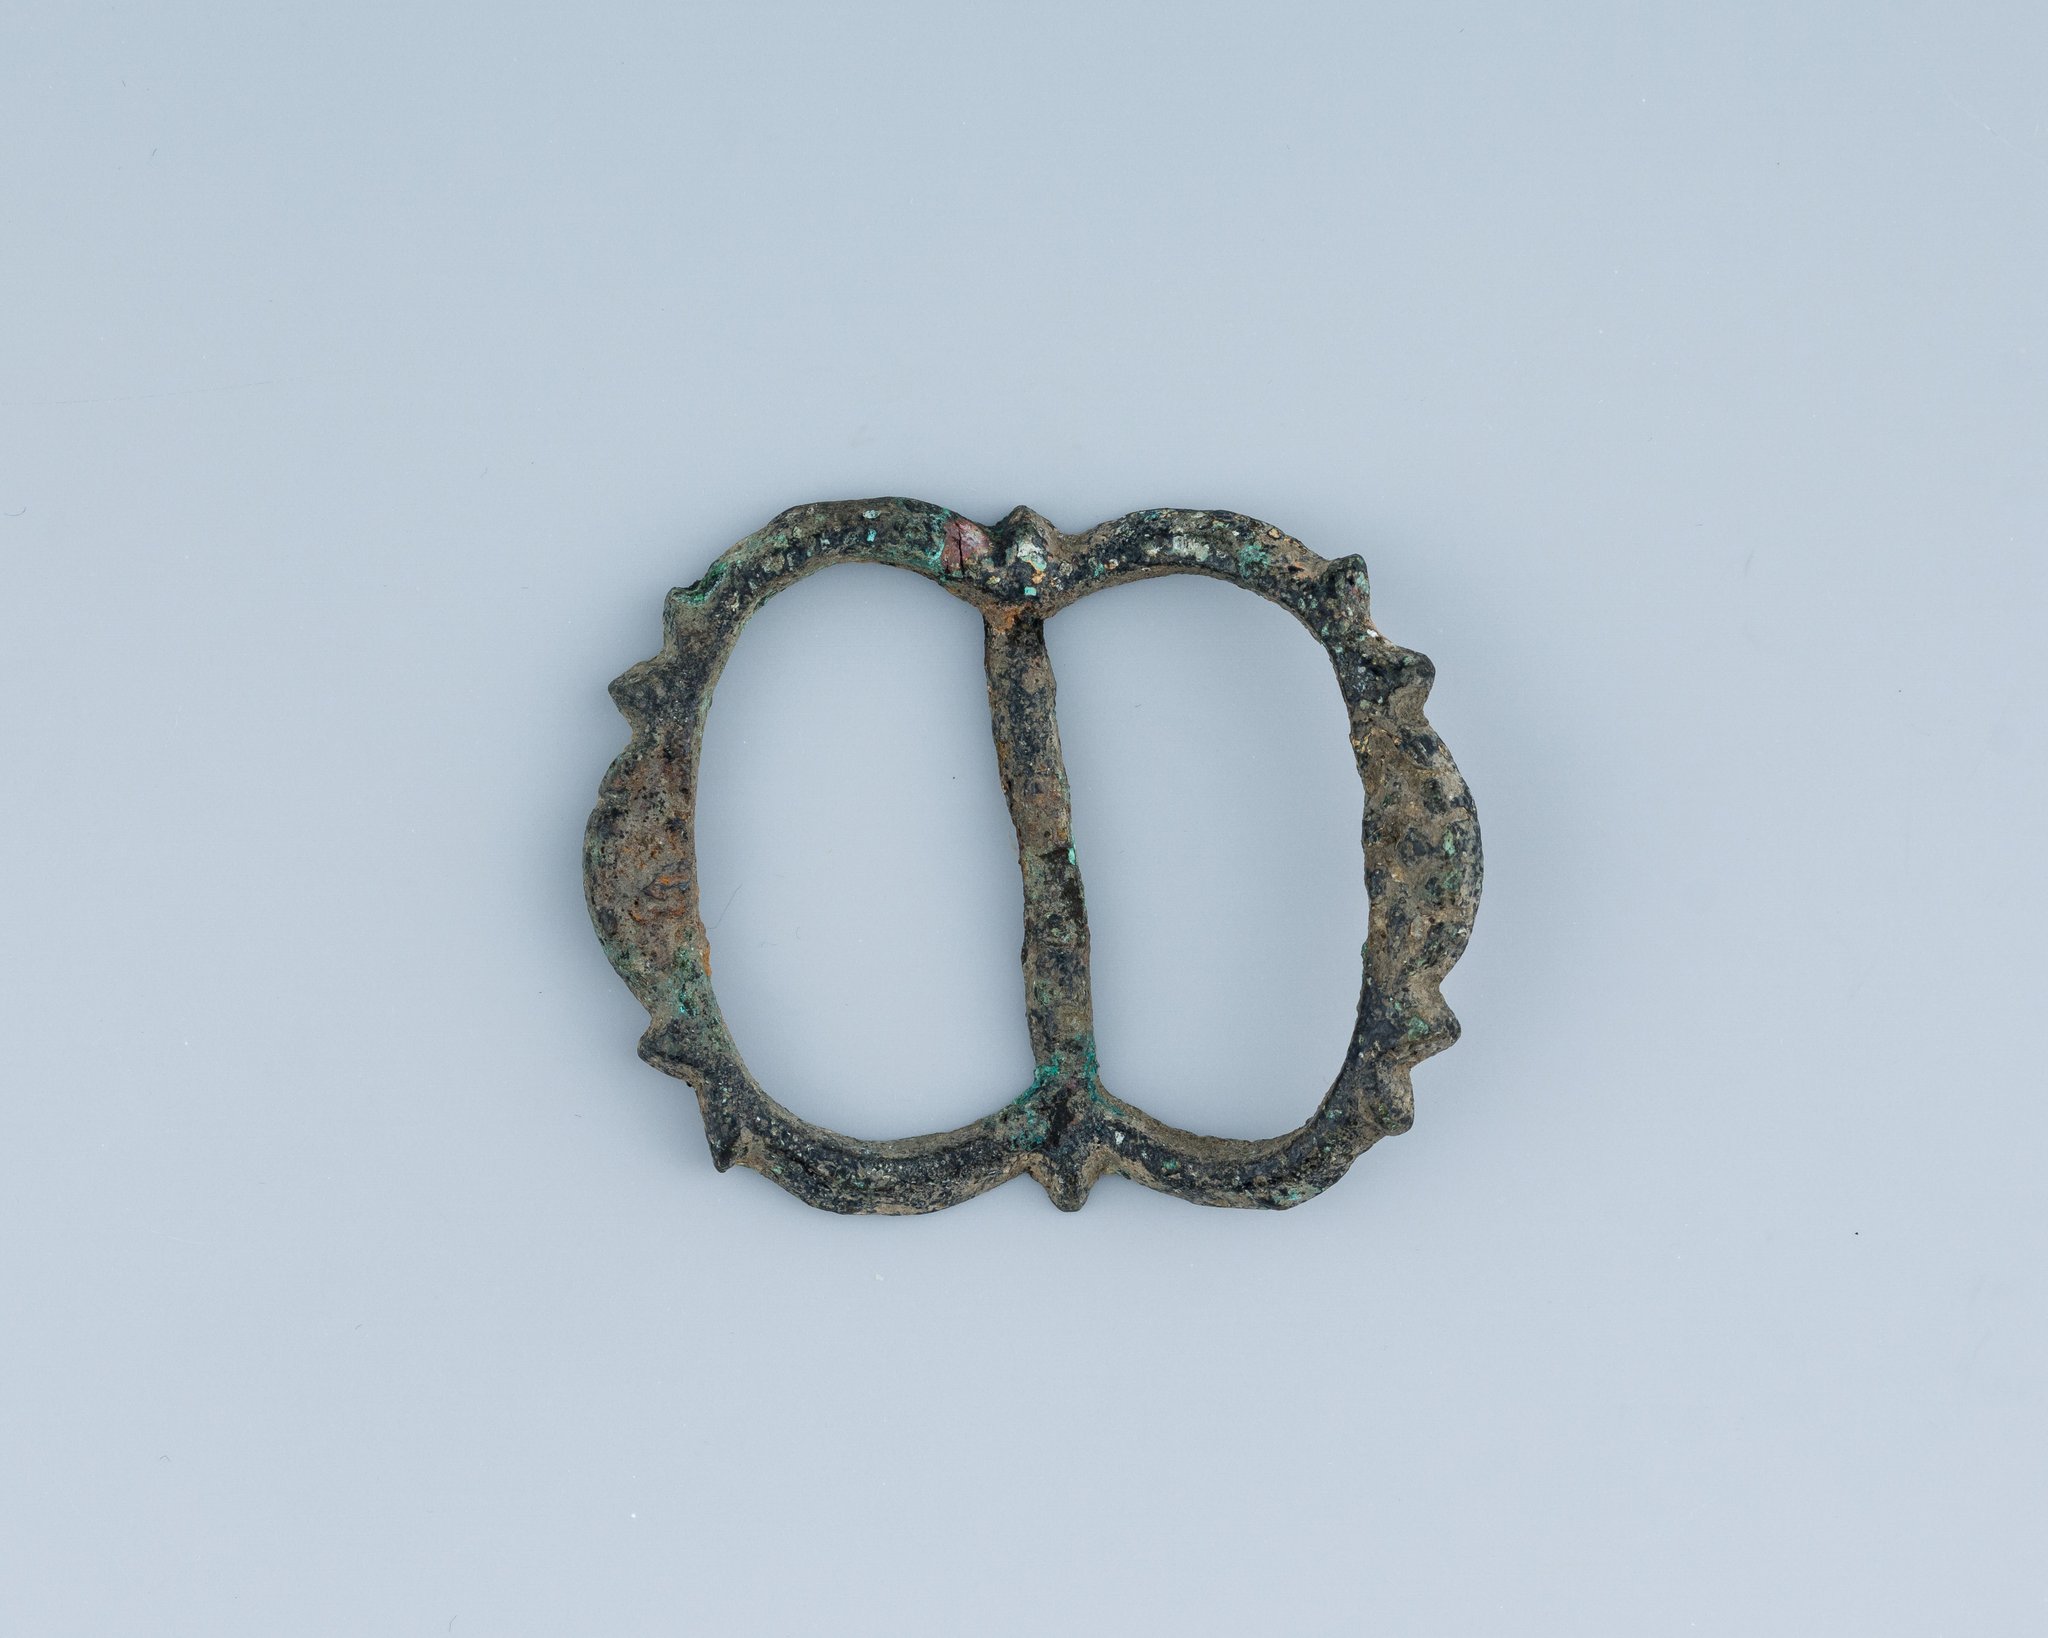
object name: buckle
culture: european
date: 1401-1600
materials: bronze, patina